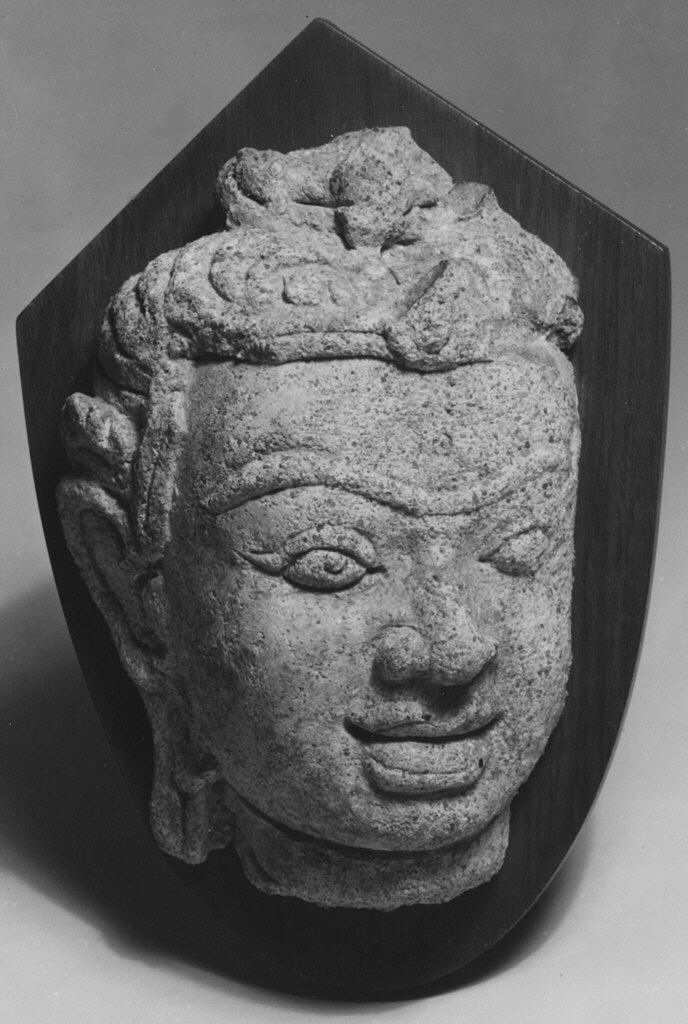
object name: head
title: Head of a Bodhisattva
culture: thai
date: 801-900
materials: plaster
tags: heads,buddhism,bodhisattvas